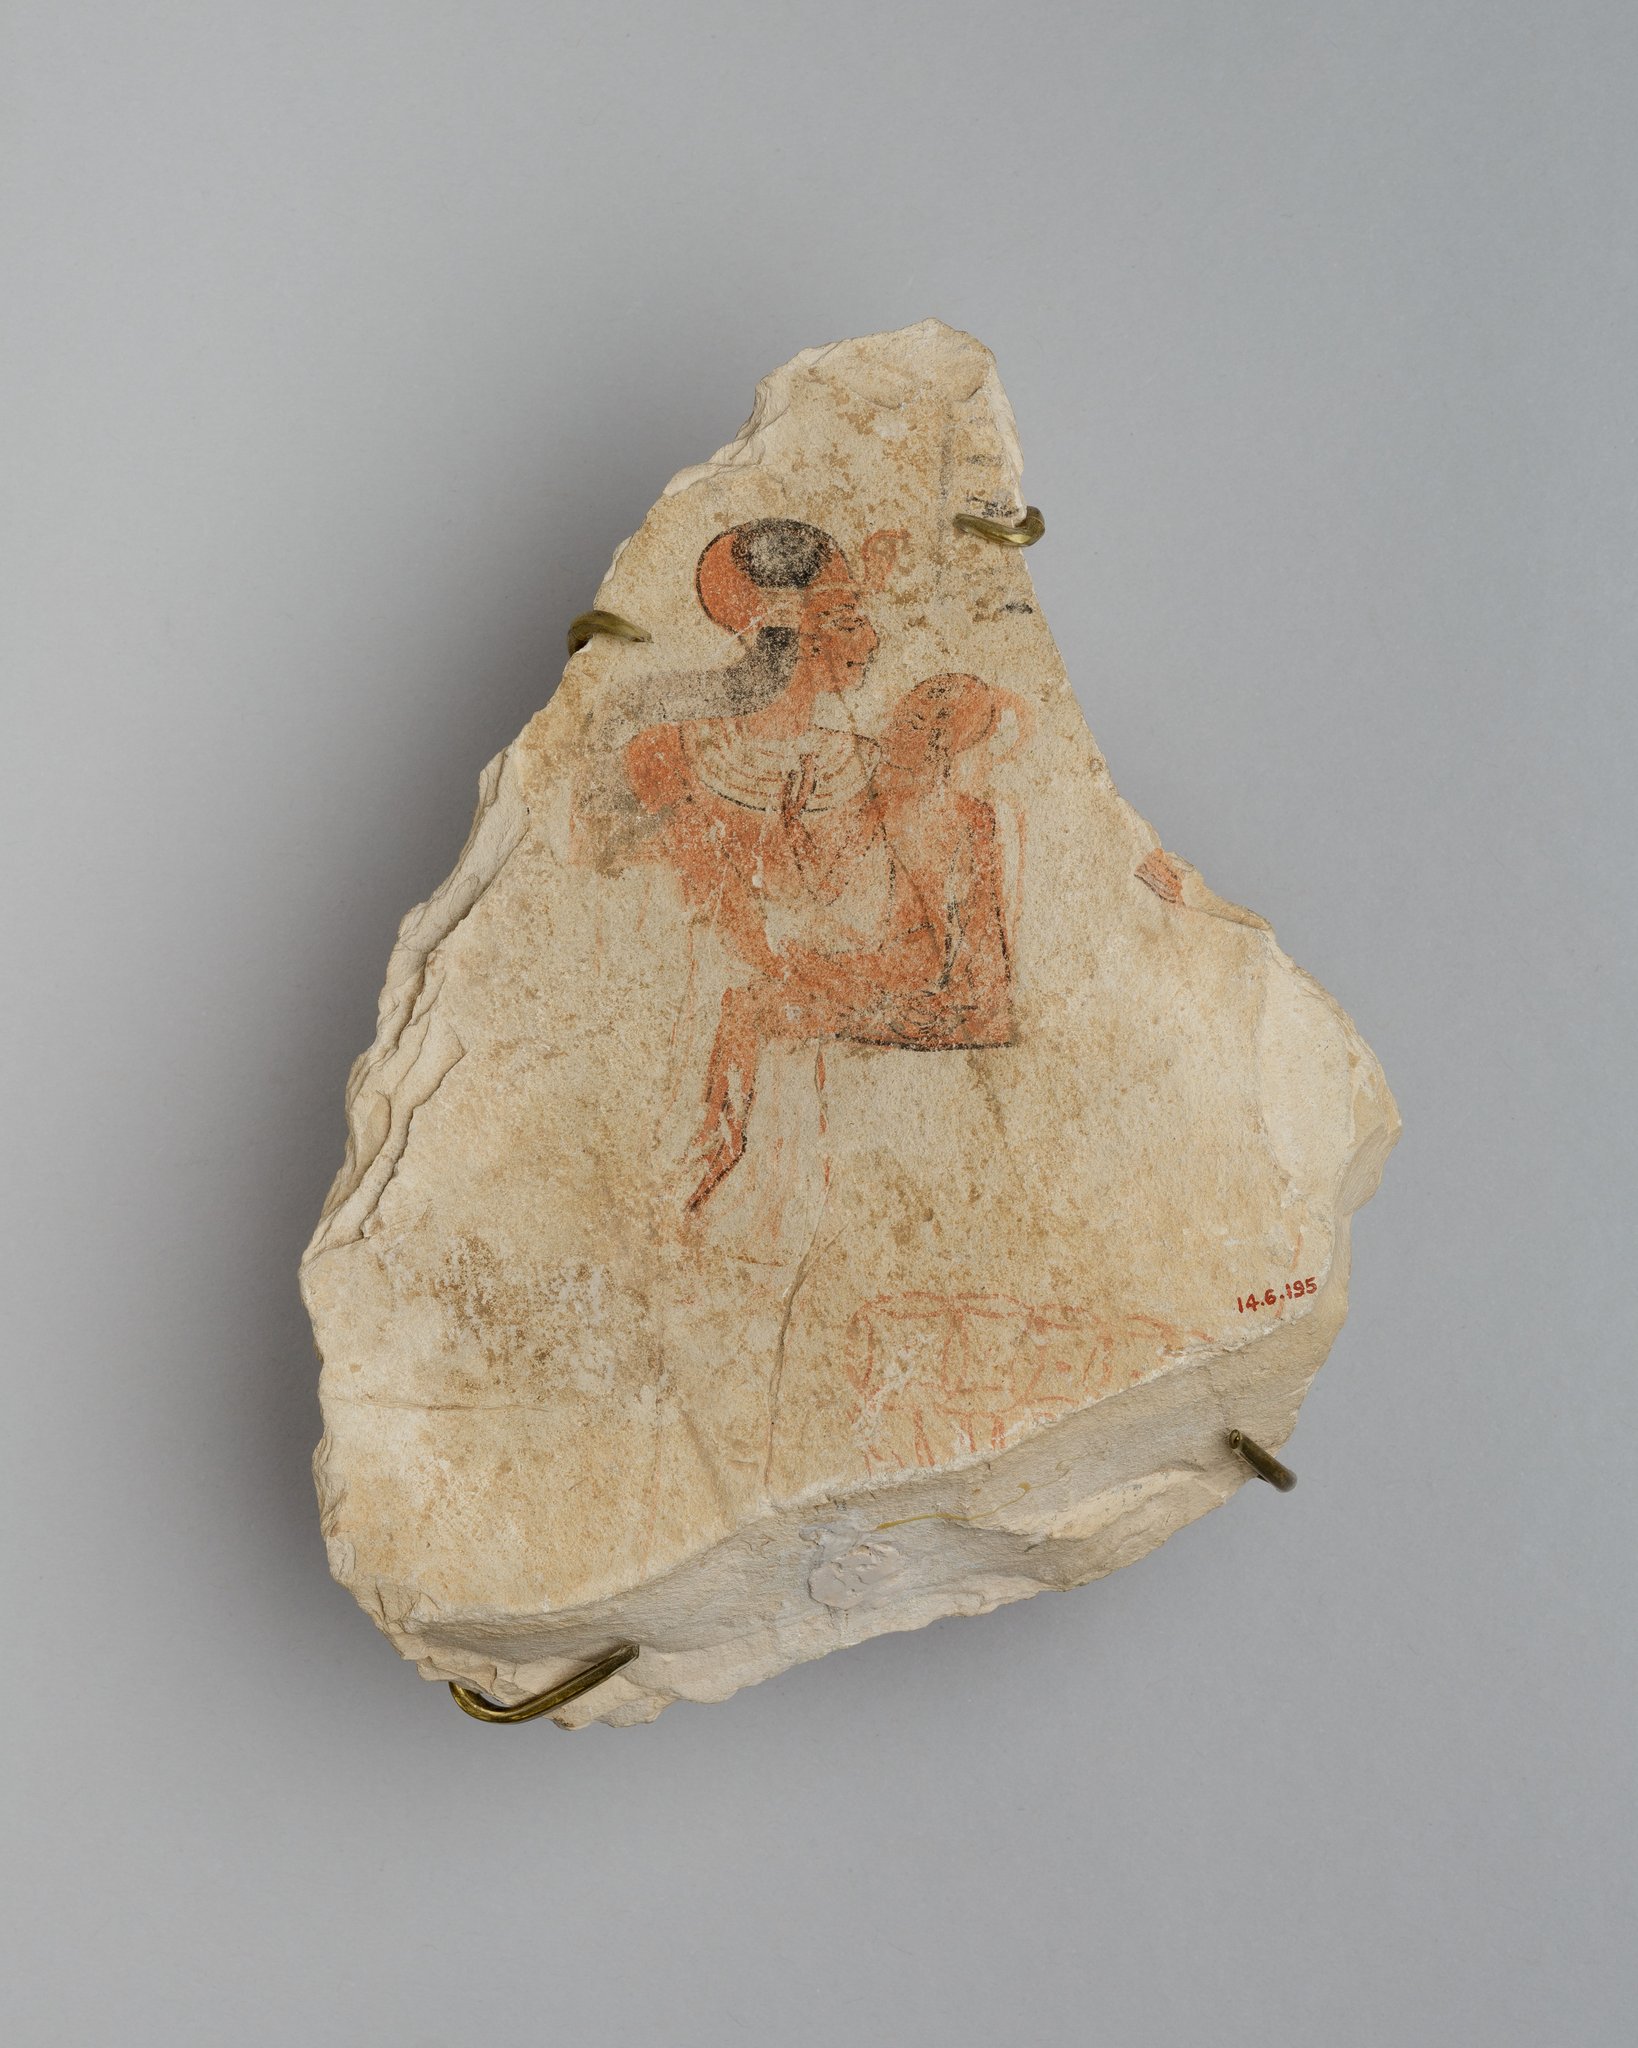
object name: ostracon, figured, woman and child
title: Ostracon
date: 1295-1070 BCE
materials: limestone, paint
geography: egypt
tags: children,women